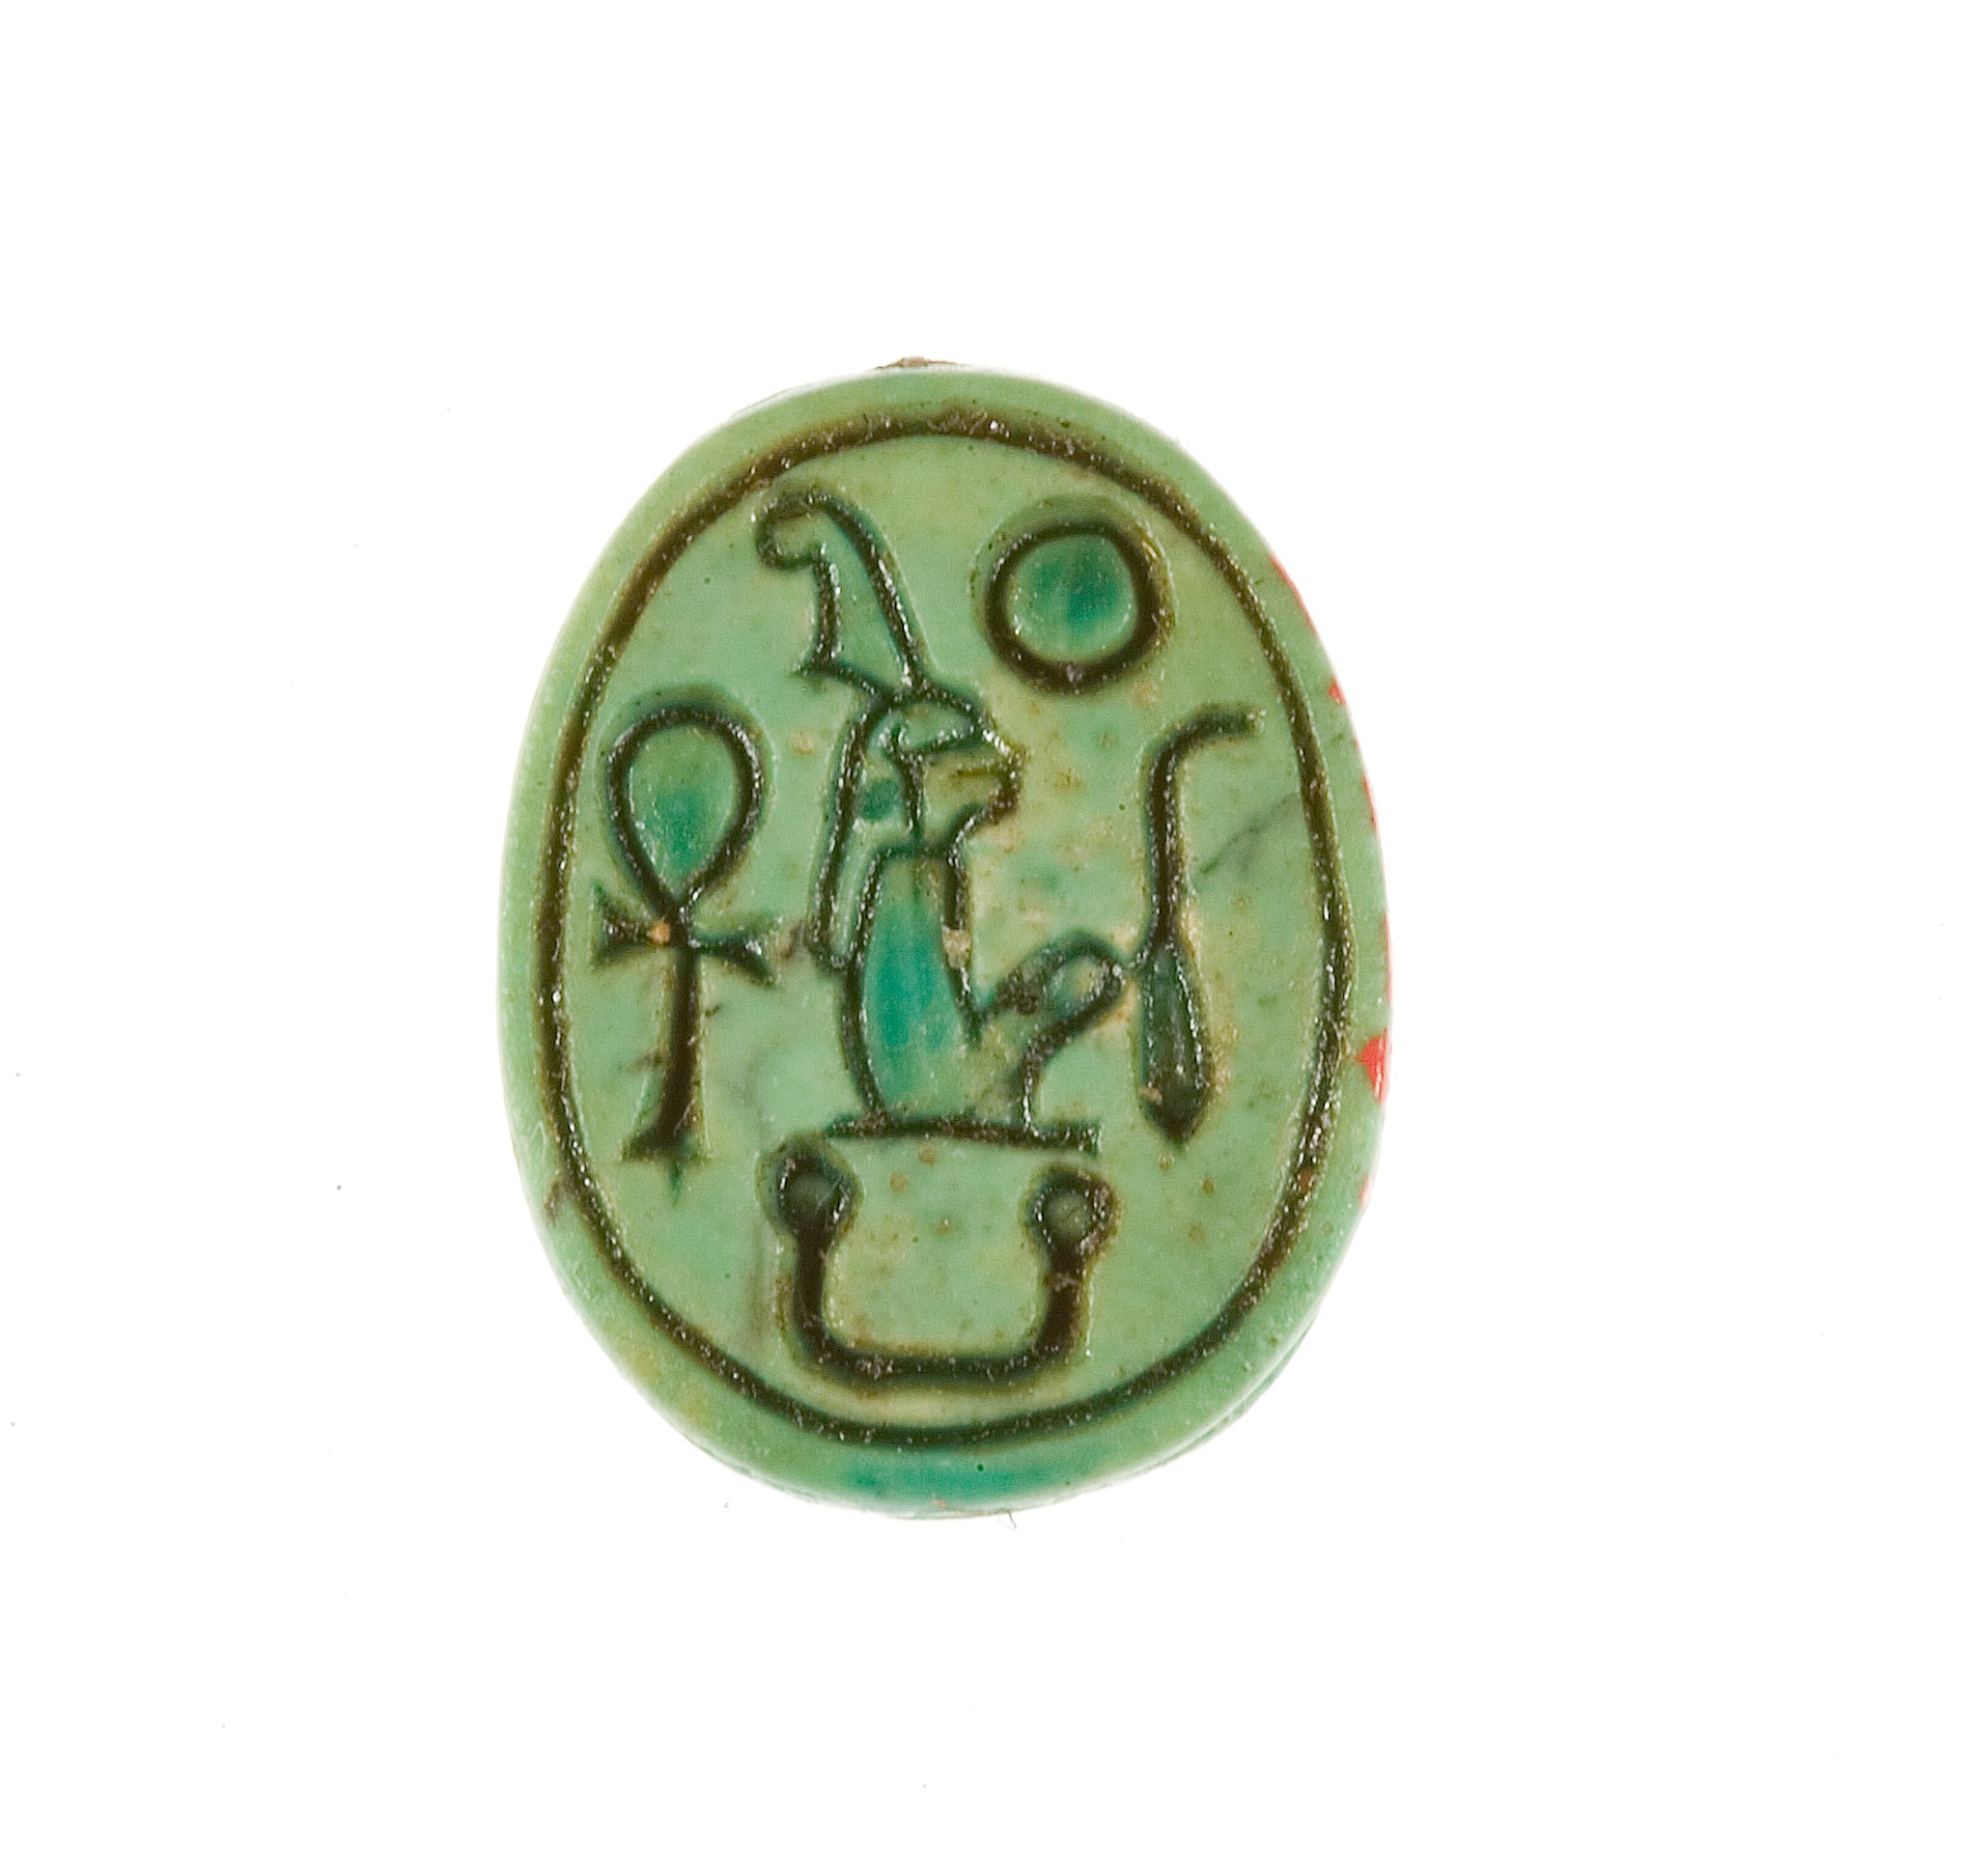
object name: scarab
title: Scarabs from Hatshepsut Foundation Deposits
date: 1479-1458 BCE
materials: stone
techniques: glazing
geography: egypt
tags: hieroglyphs,scarabs